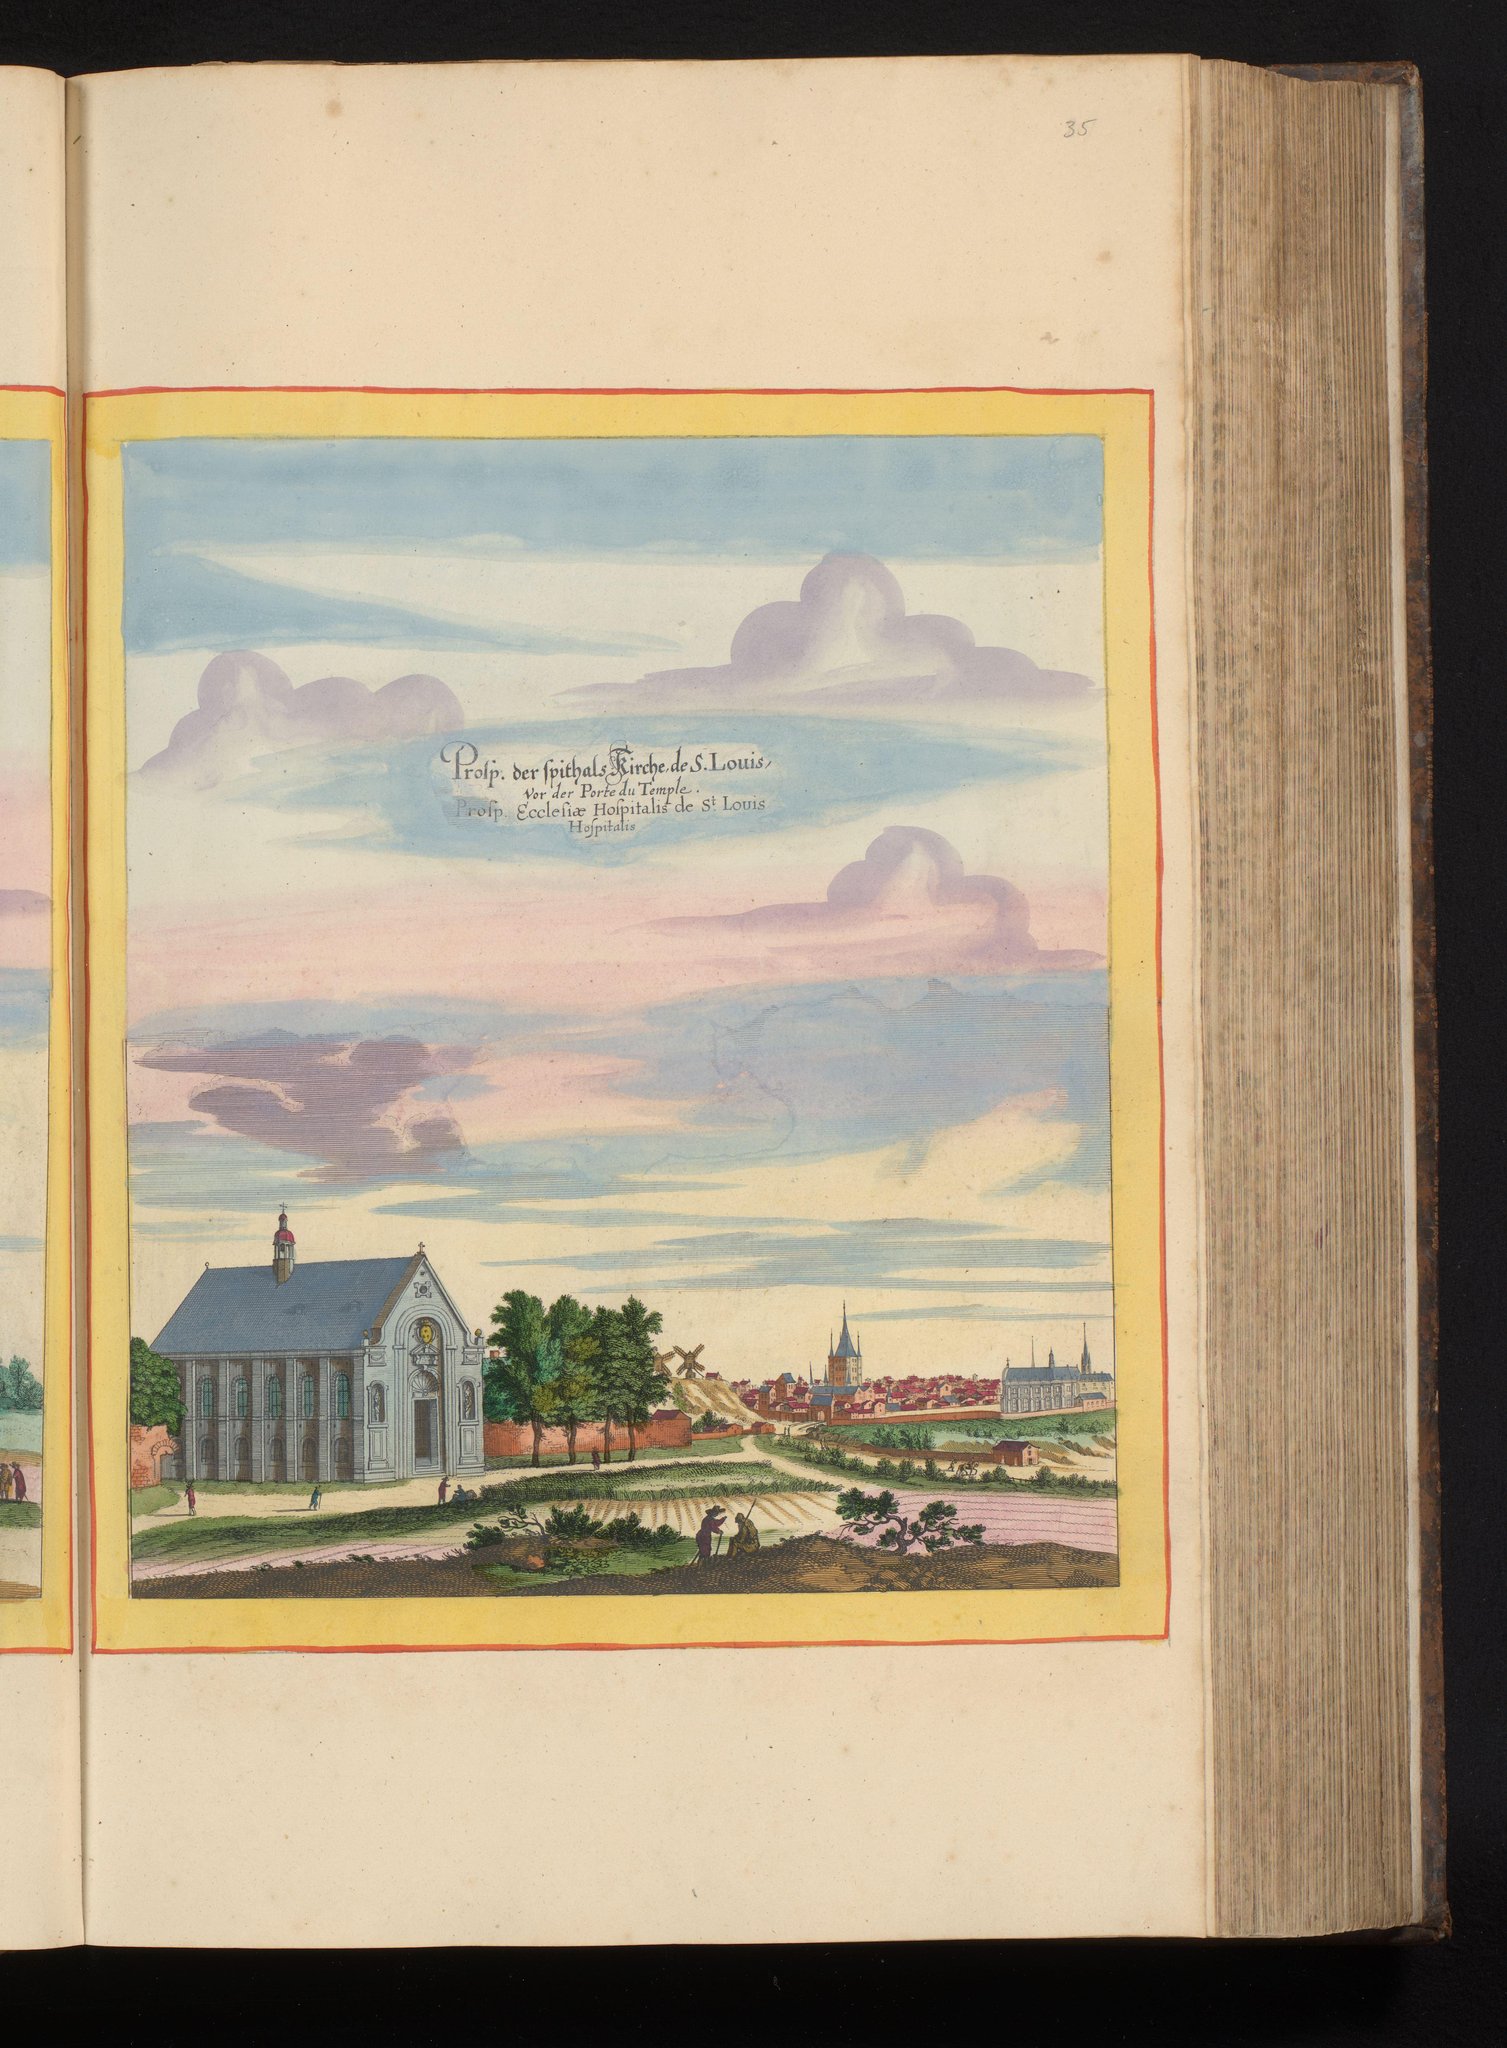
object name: print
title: Prosp. der spitals Kirche de S. Louis vor der Porte du Temple (...)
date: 1655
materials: paper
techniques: engraving, etching, hand coloring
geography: the hague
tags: church (exterior)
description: Prent origineel vervaardigd als boekillustratie voor: Zeiller, Martin. Topographia Galliae, oder Beschreibung und Contrafaitung der vornehmbsten und bekantisten Oerter in dem mächtigen und grossen Königreich Frankreich, 13 delen. Frankfurt am Main: Caspar Merian, 1655-1661. De prent werd voor het eerst gepubliceerd in deel 1: Topographia Galliae, 1655.